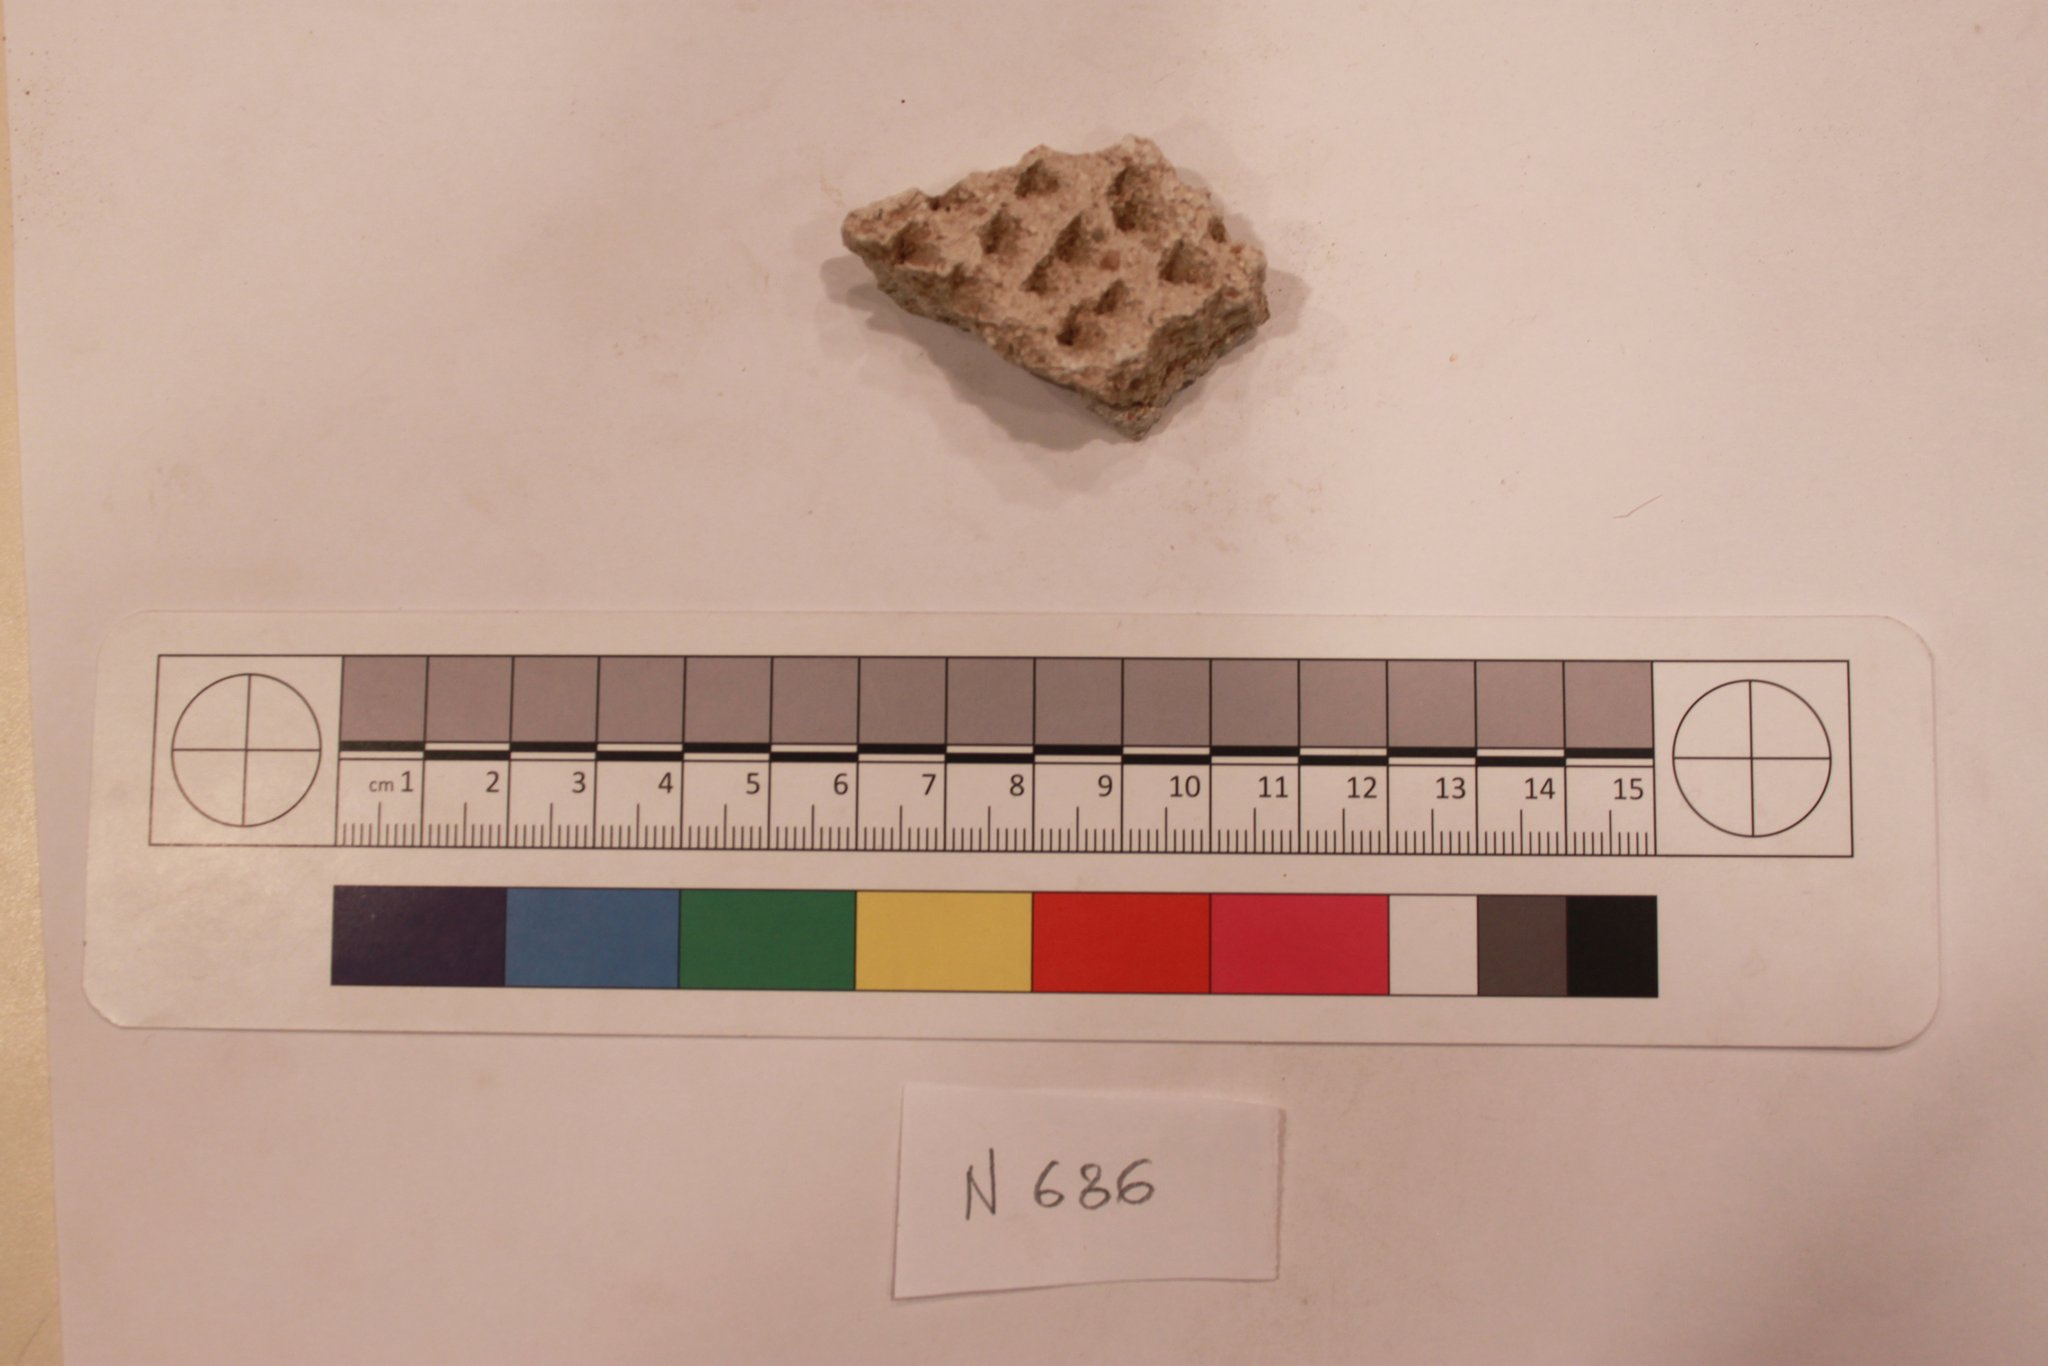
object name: fragment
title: Stucco Fragment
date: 701-1200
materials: plaster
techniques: carving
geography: iran